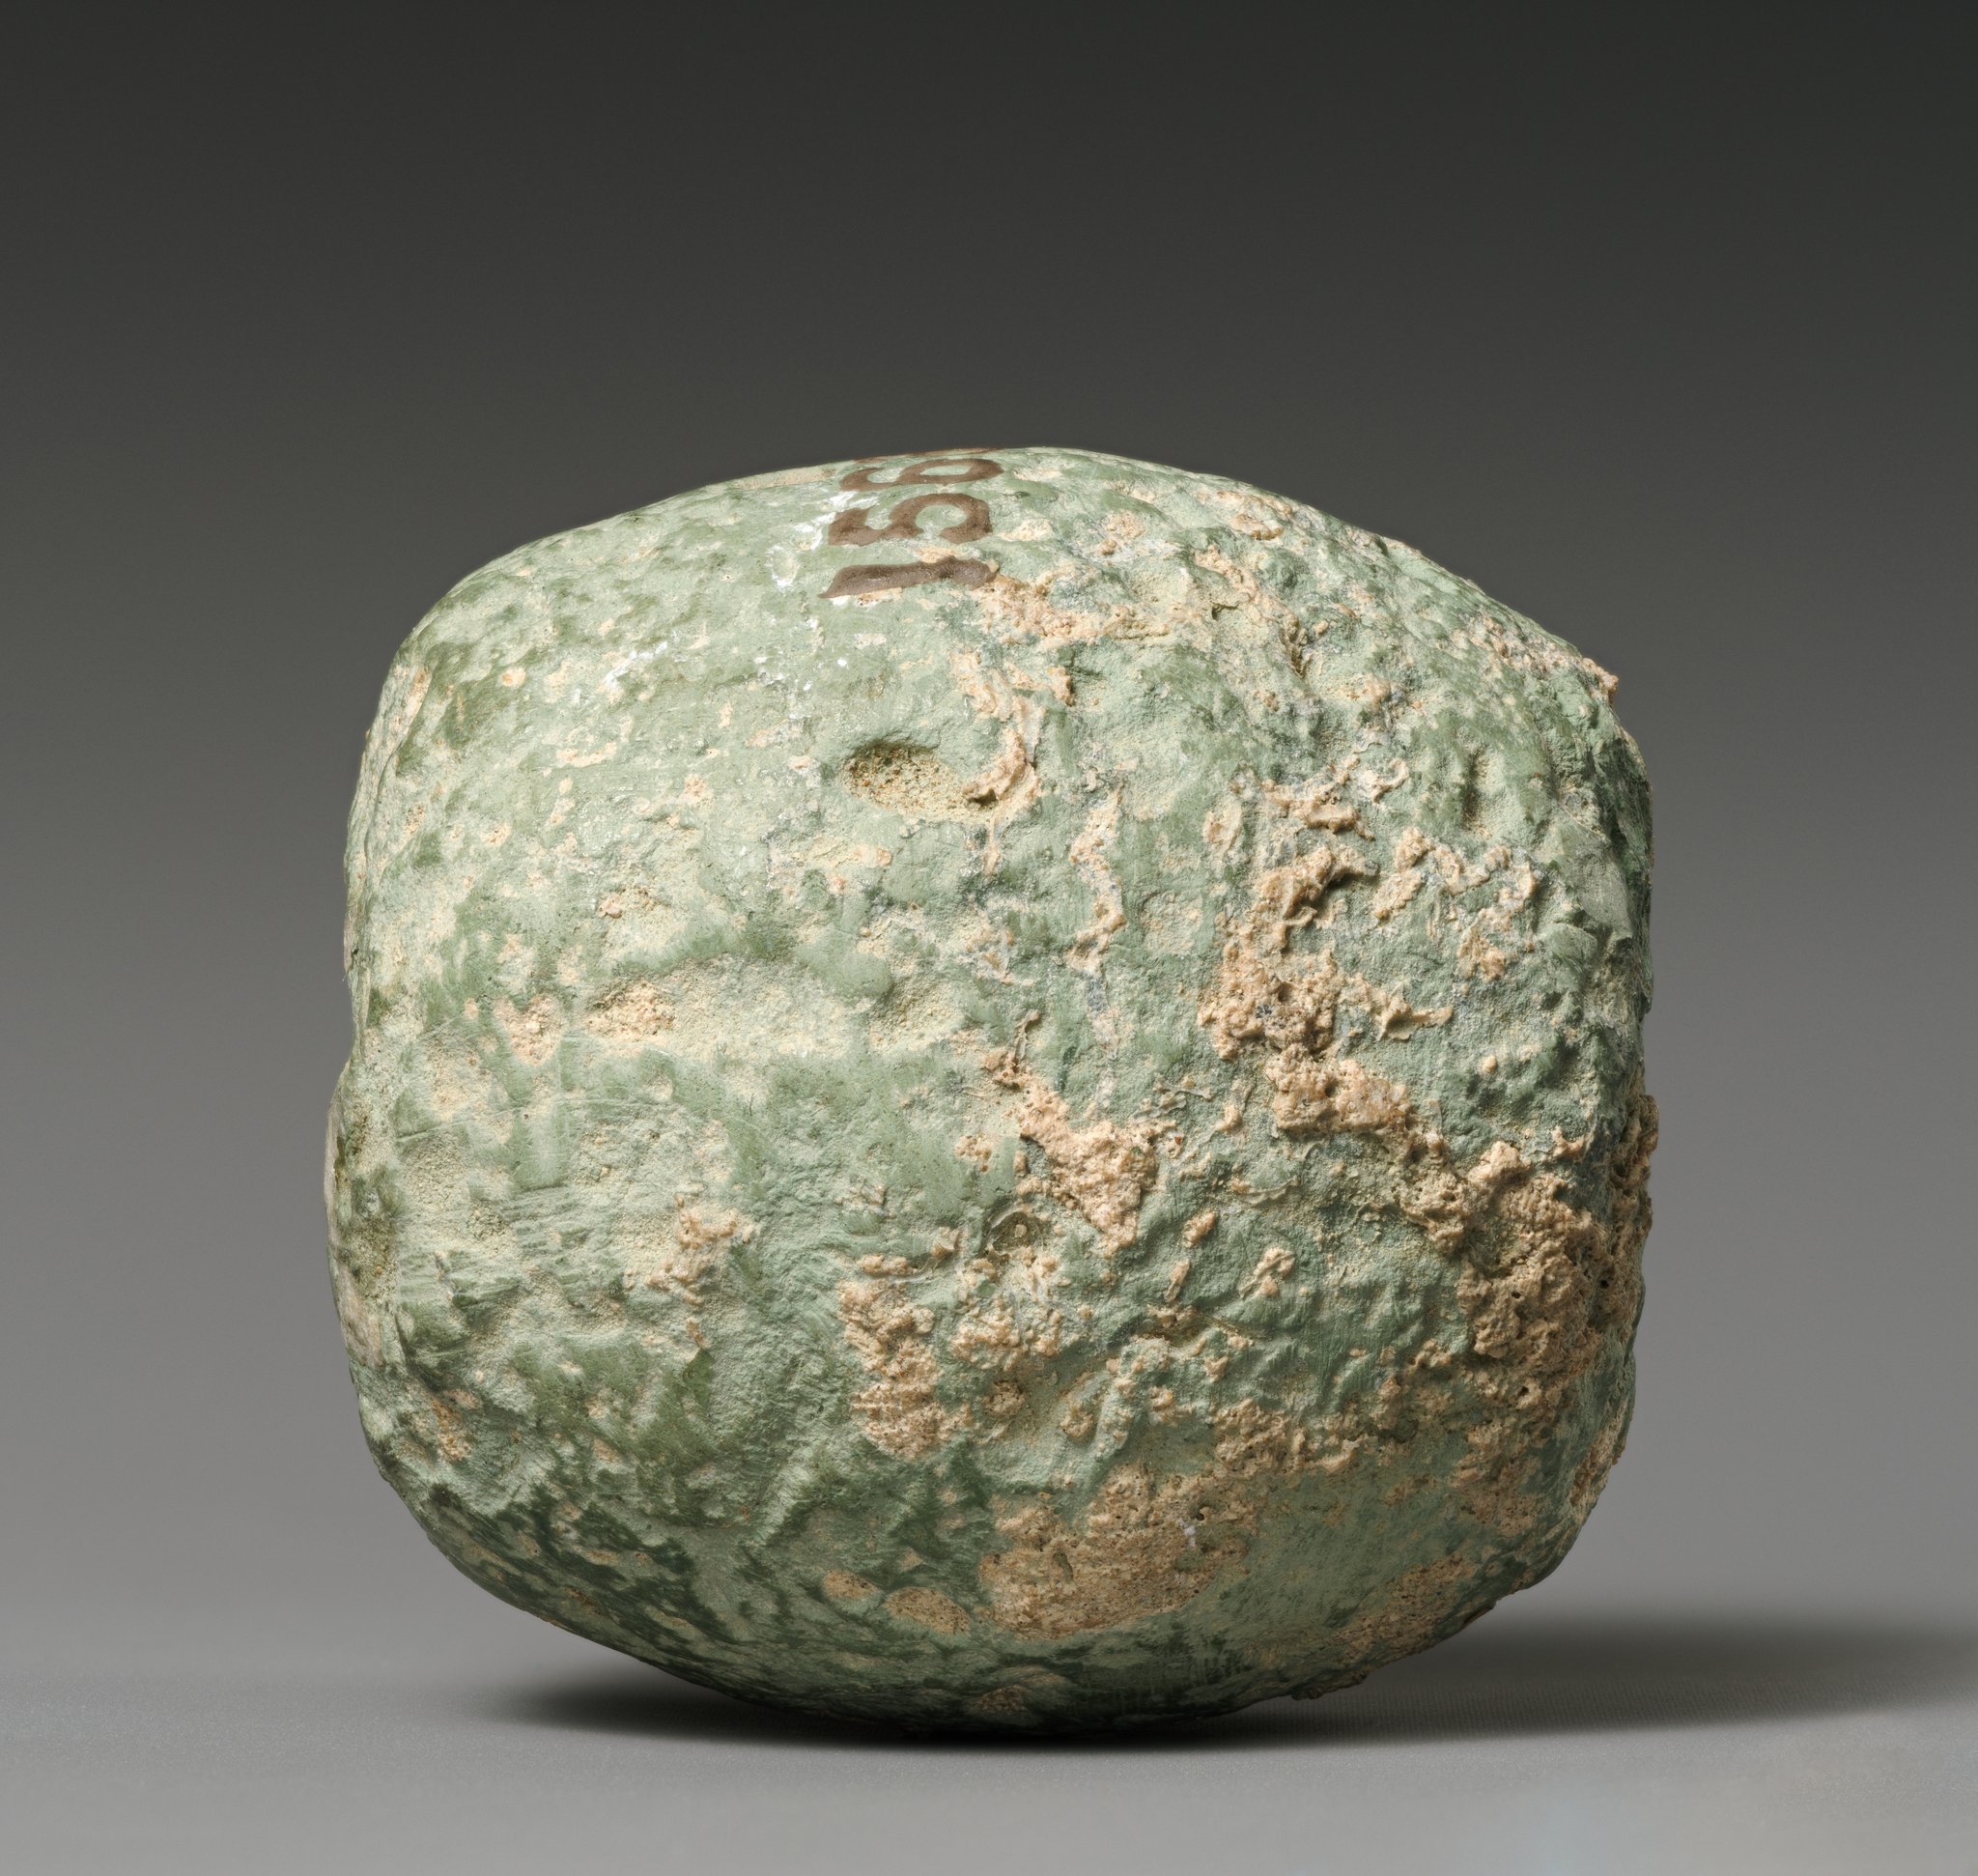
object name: spindle whorl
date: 4000-3001 BCE